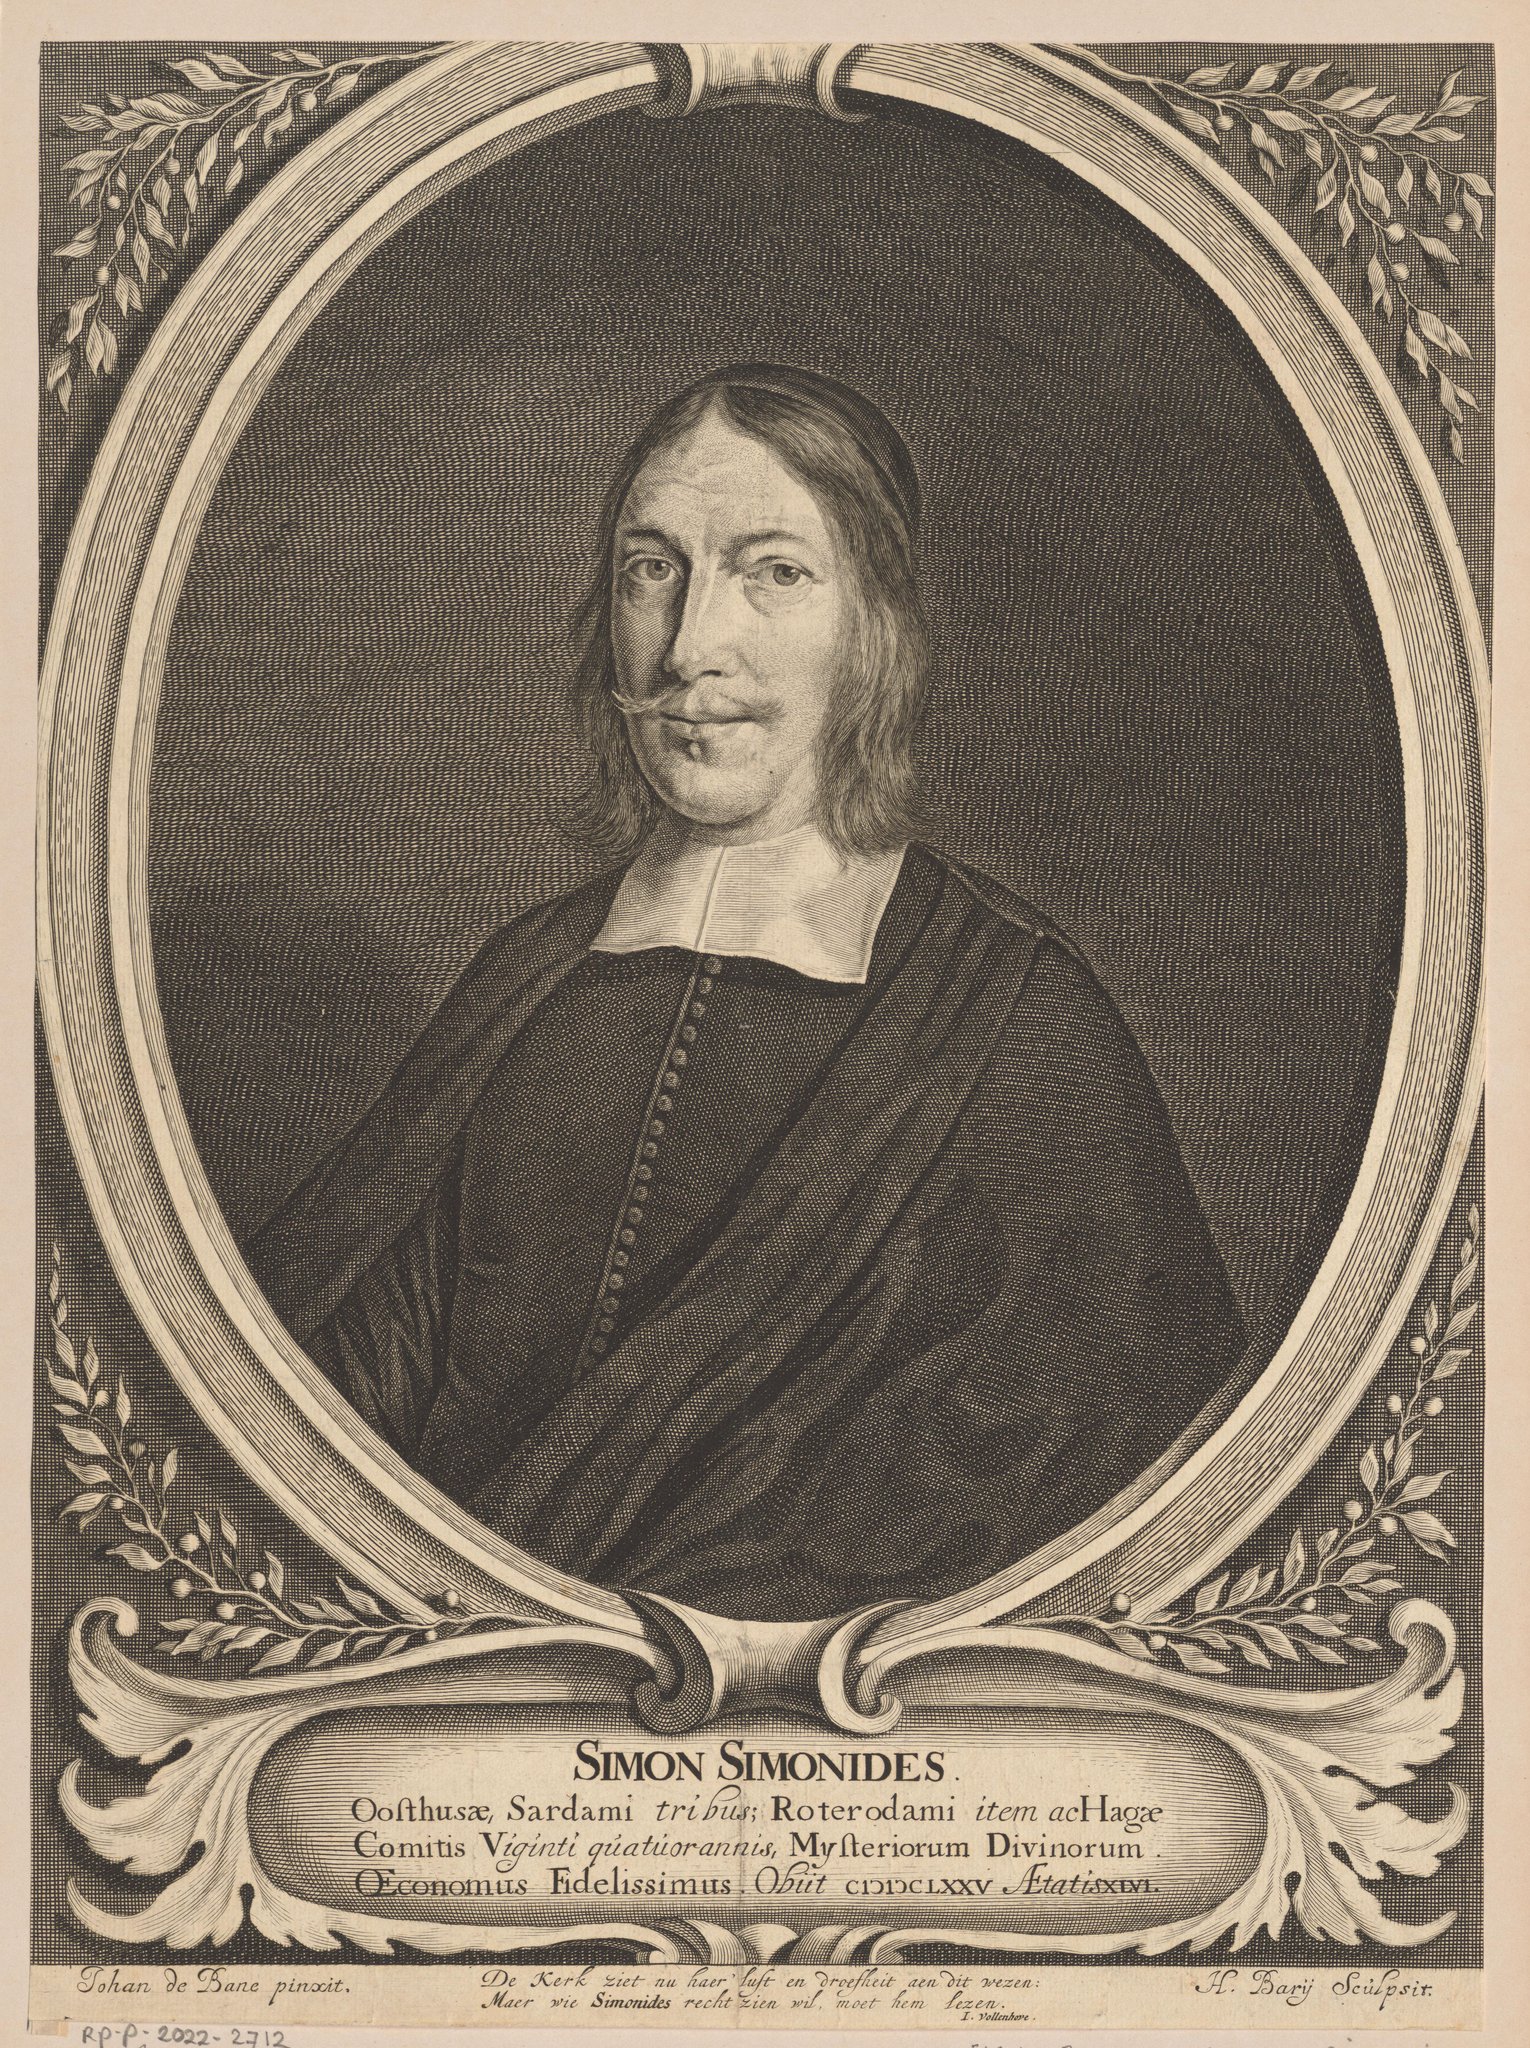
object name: print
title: Portret van Simon Simonides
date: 1675-1707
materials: paper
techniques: engraving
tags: historical persons, portrait of a writer, functionaries and dignitaries (with name) ~ episcopal protestant churches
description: Met drieregelig onderschrift in het Latijn en tweeregelig onderschrift in het Nederlands.